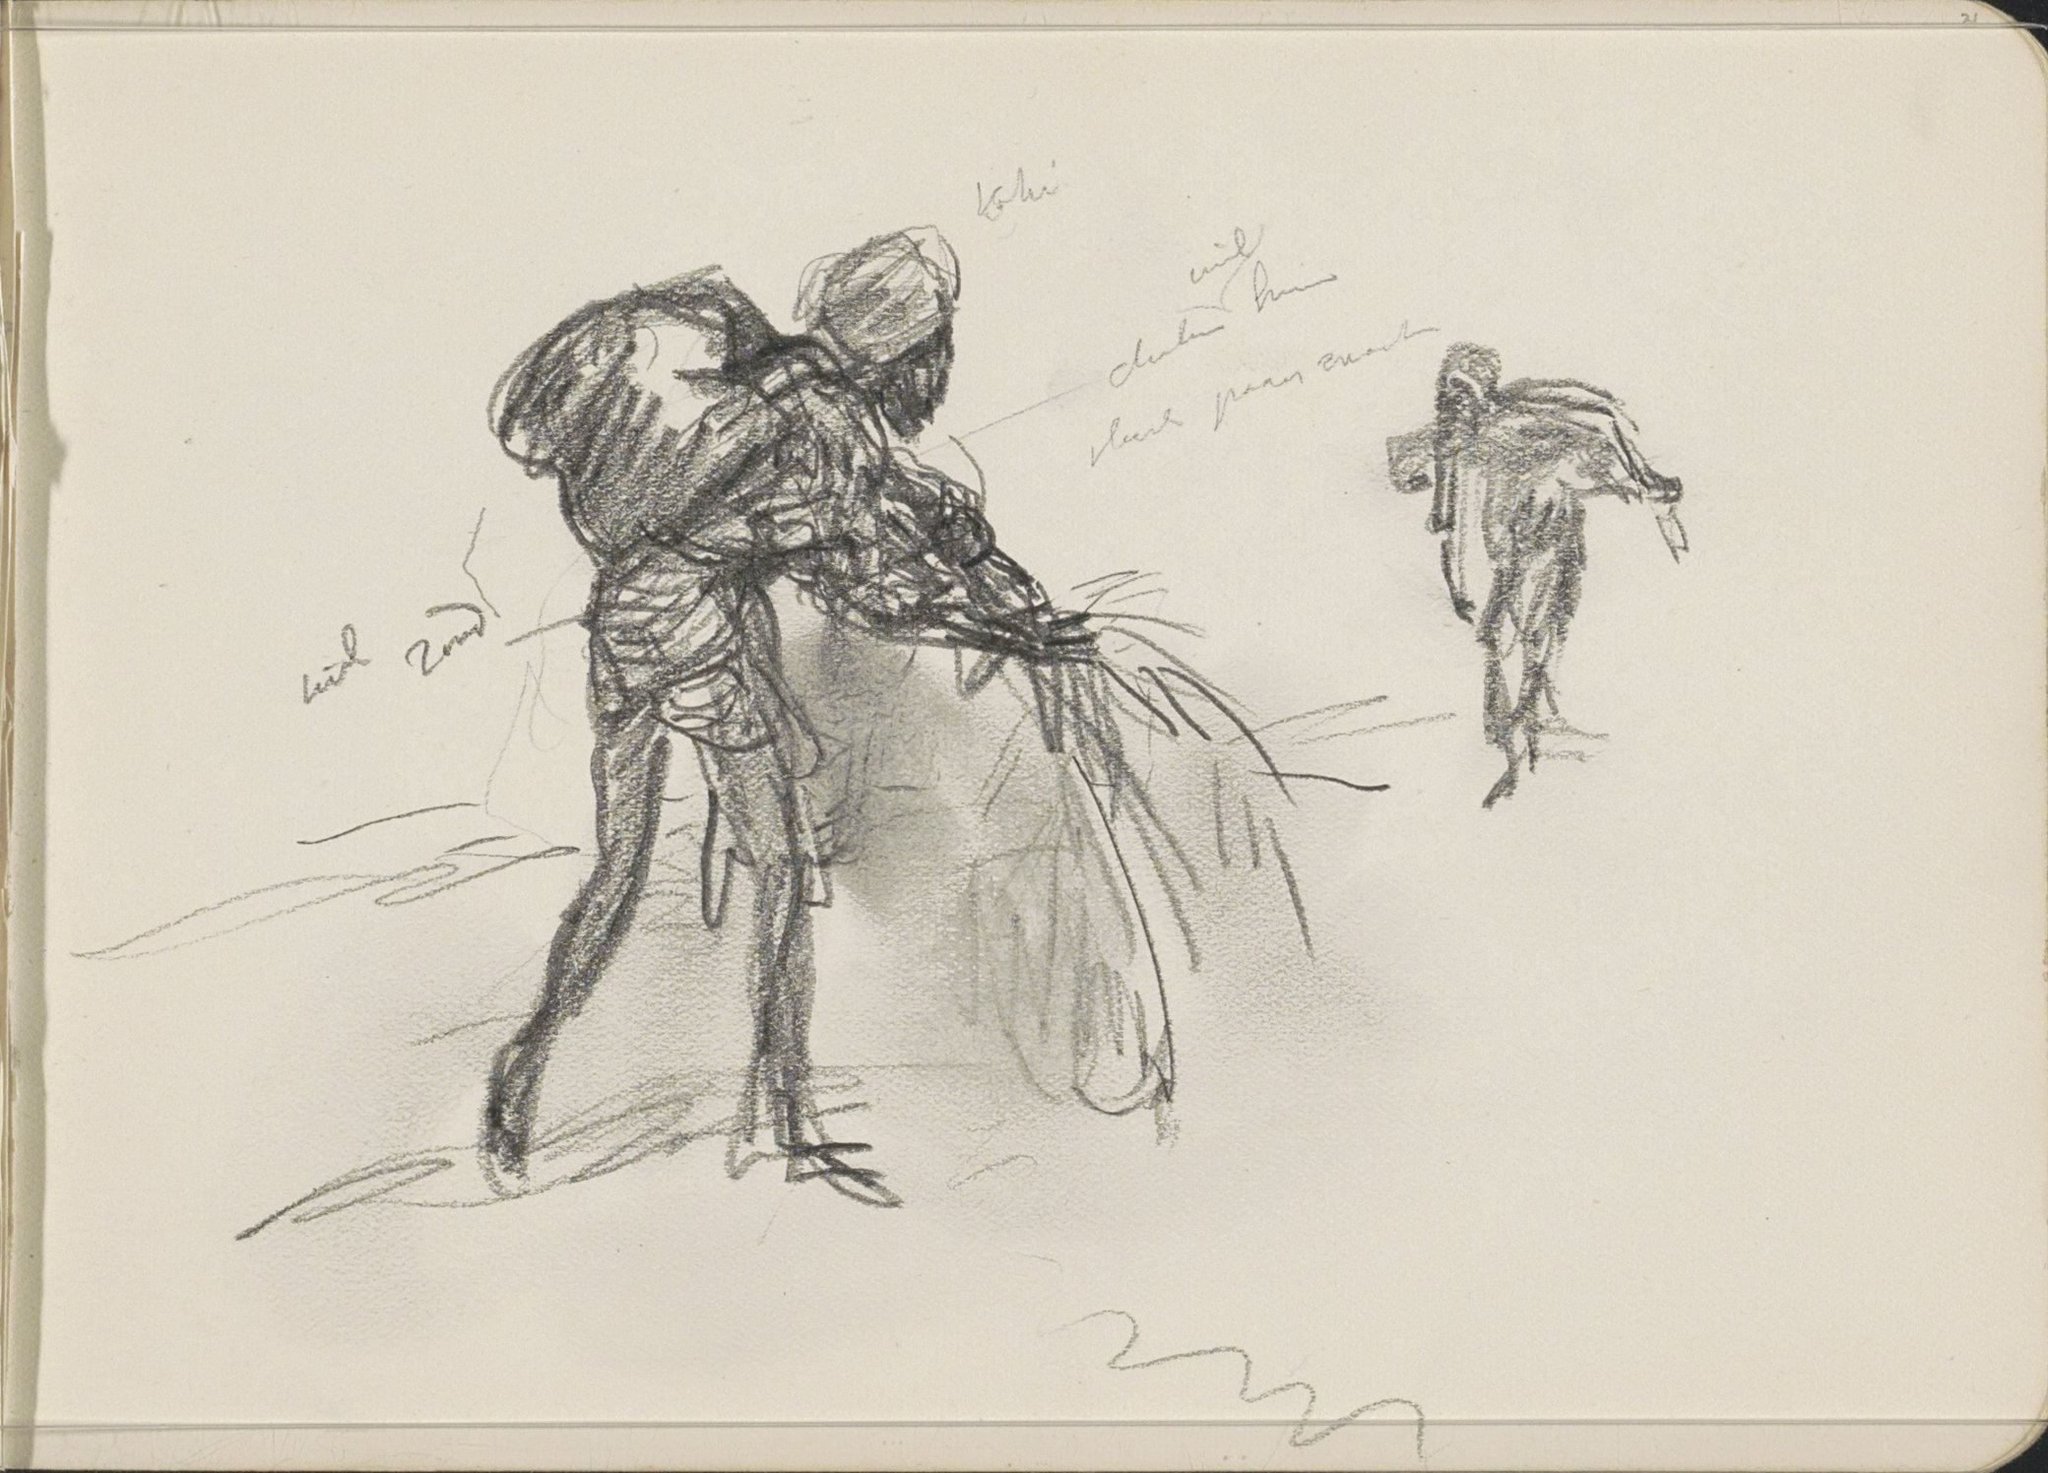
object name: sketchbook leaf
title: Indiër met een zak op de rug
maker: marius bauer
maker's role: draughtsman, print maker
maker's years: 1867-1932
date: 1925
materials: paper, pencil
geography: india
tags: head-gear: turban, asiatic races and peoples: indians, carrying something on the head or on the shoulders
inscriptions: kleurnotitie, handgeschreven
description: Pagina 21 uit een schetsboek met 15 bladen.